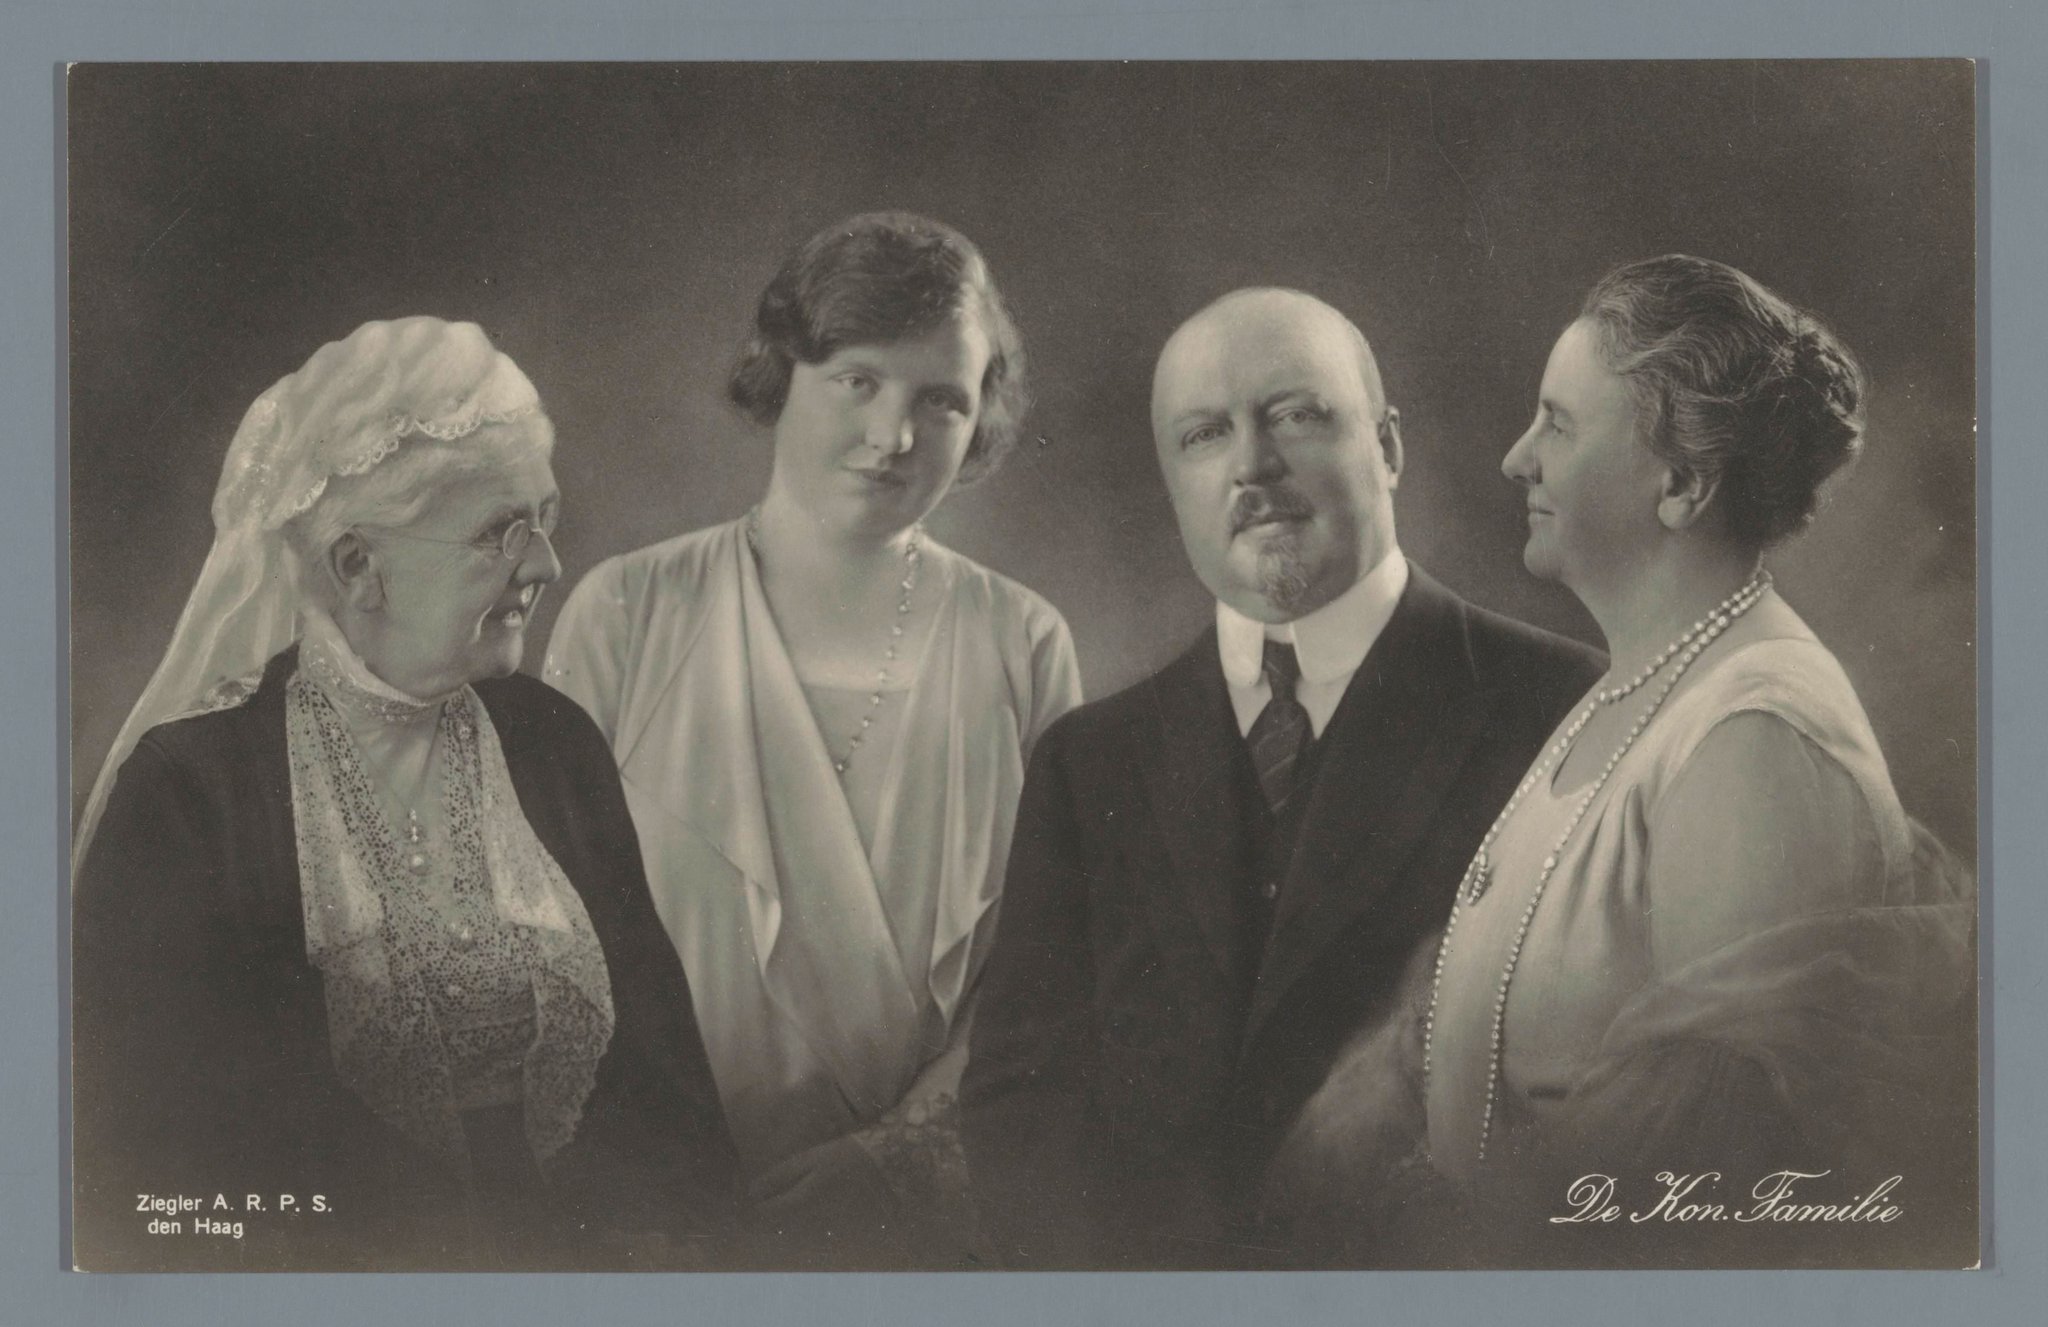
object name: photograph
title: De kon. familie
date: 1929-1933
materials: photographic support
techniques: gelatin silver print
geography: the hague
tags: print maker, wilhelmina of the netherlands, emma (queen consort of the netherlands), hendrik (prins der nederlanden), juliana of the netherlands, crown princess, prince, queen, family of the sovereign